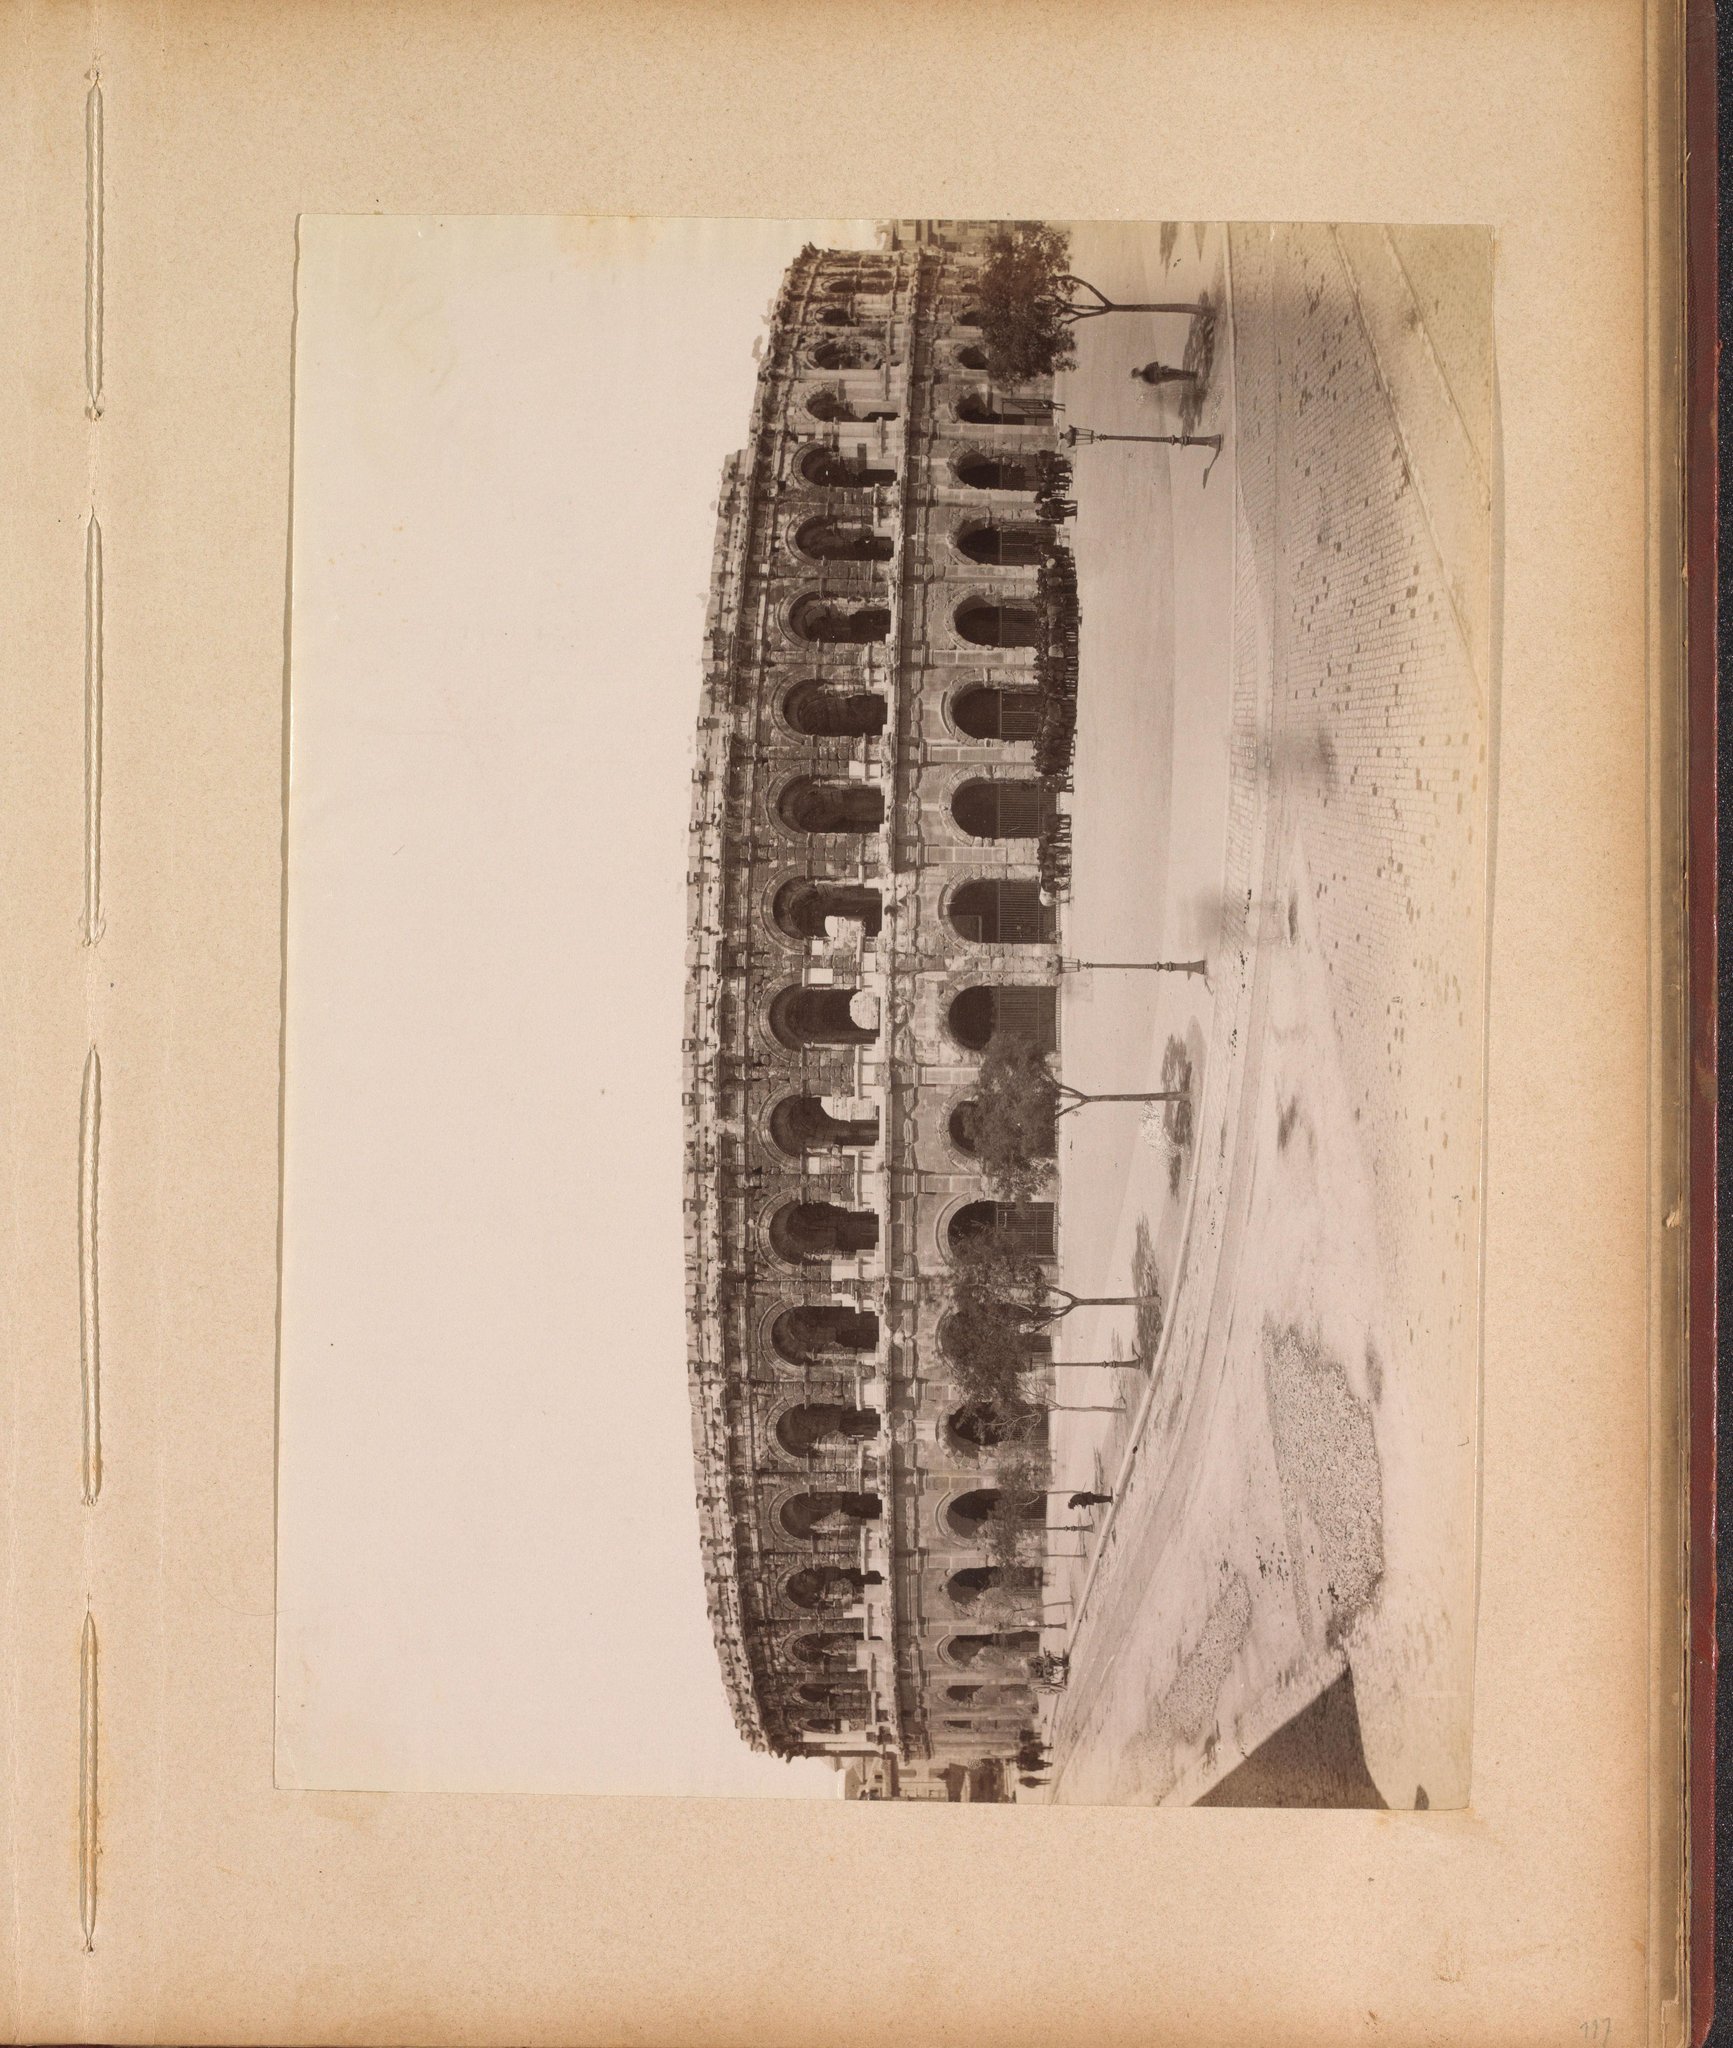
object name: photograph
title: Exterieur van de arena van Nîmes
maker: Anonymous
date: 1870-1900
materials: paper, photographic support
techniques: albumen print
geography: southern france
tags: grounds, fields and accomodations for sports, games and physical performances (+ out of doors (sports, games, etc.))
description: Onderdeel van Reisalbum met foto's van bezienswaardigheden in Italië en Zuid-Frankrijk.